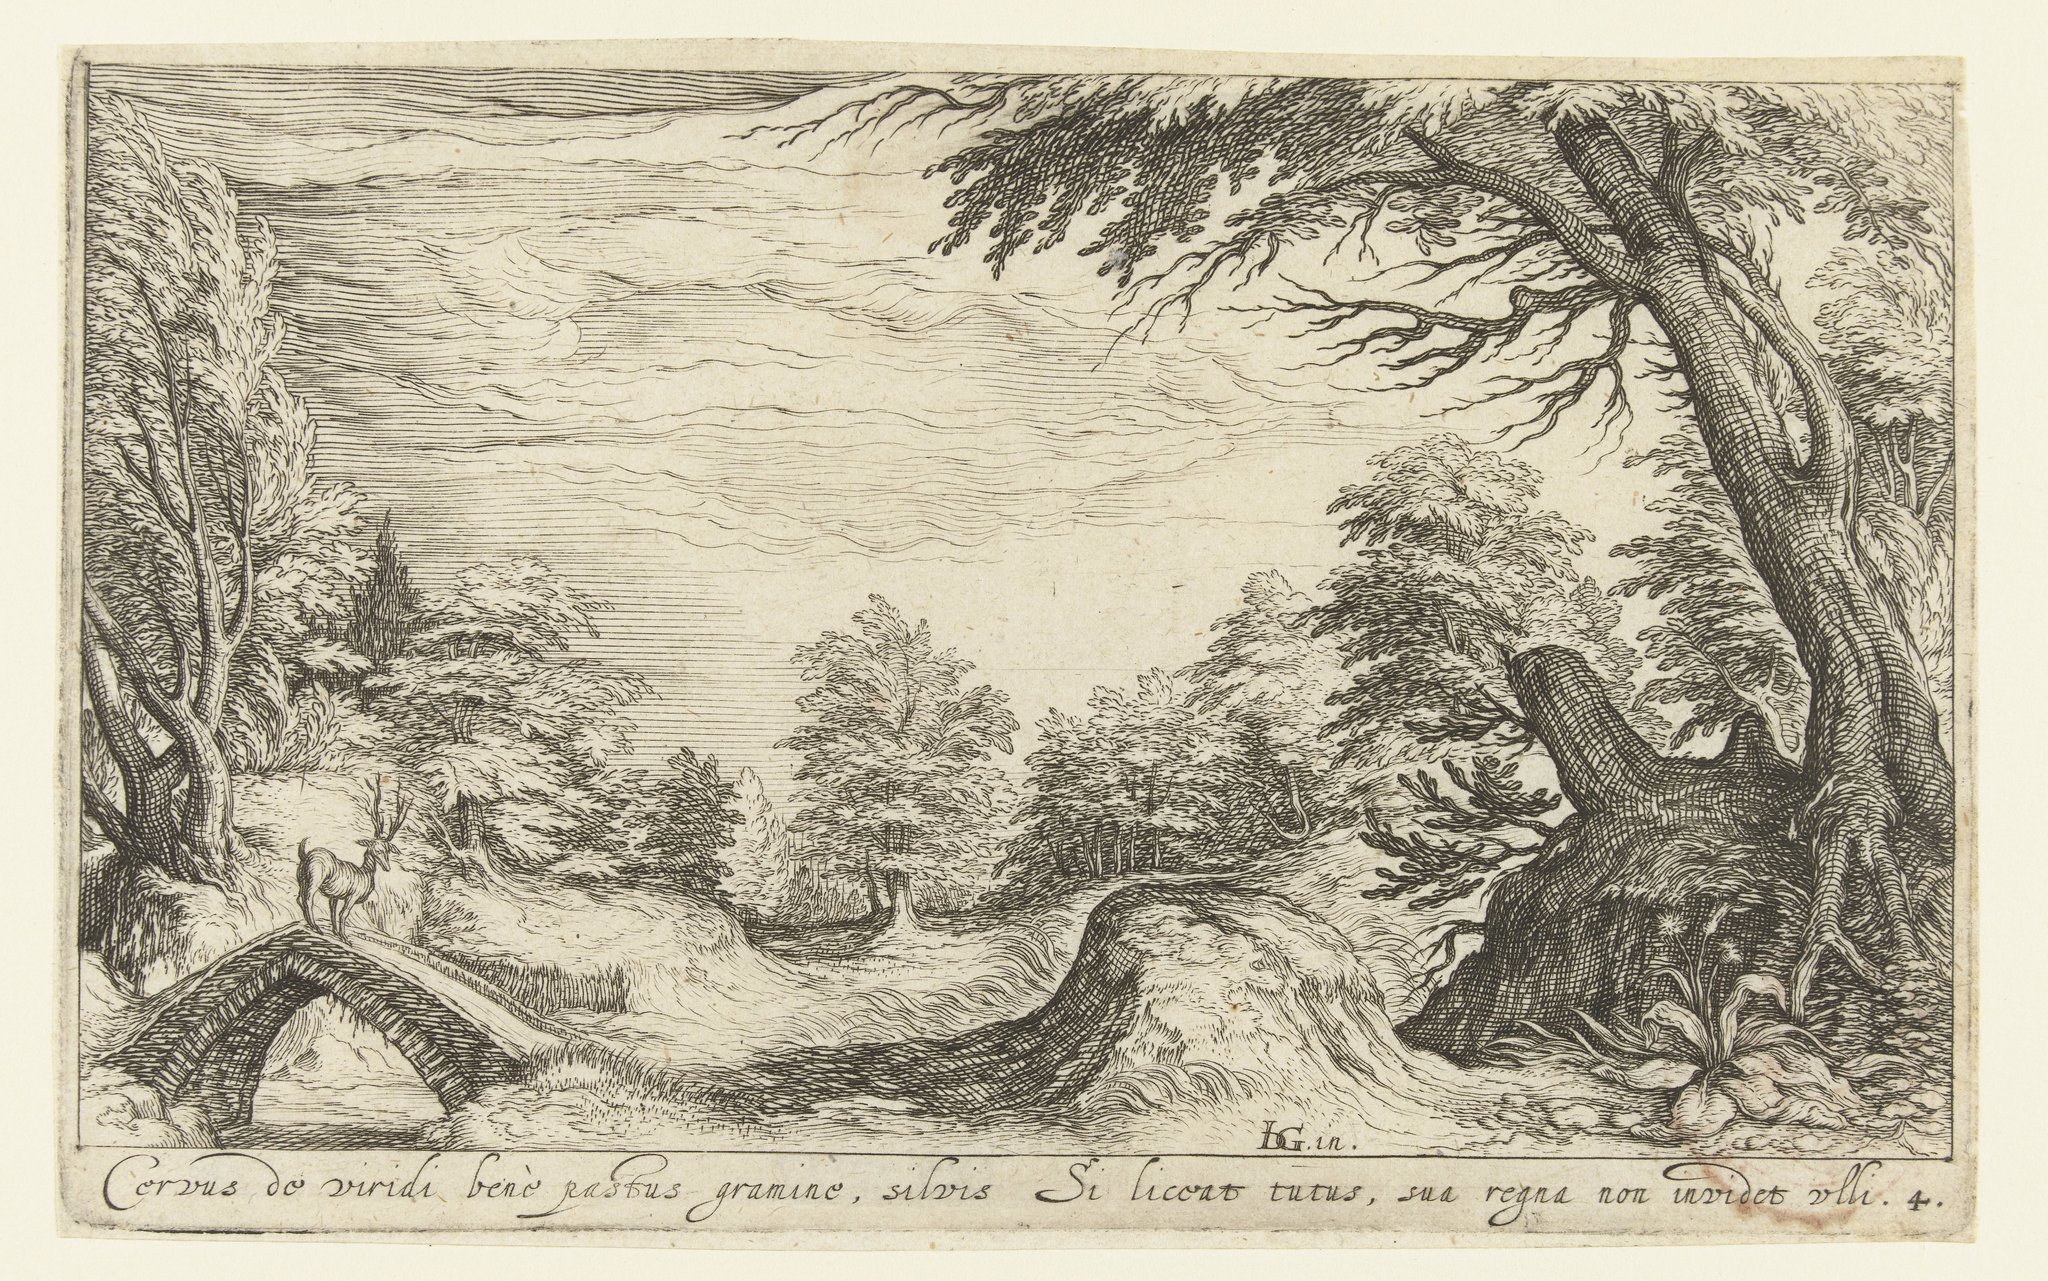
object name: print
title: Landschap met een hert op een brug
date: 1608-1612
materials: paper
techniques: engraving, etching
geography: netherlands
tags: landscapes, landscape with bridge, viaduct or aqueduct, hoofed animals: stag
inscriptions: collector's mark: Lugt 240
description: Bosachtig landschap. Links een brug over een watertje, waarop een hert staat. Onder de voorstelling één regel Latijnse tekst. Deze prent is onderdeel van een serie van zes (op één na) genummerde prenten met landschappen.